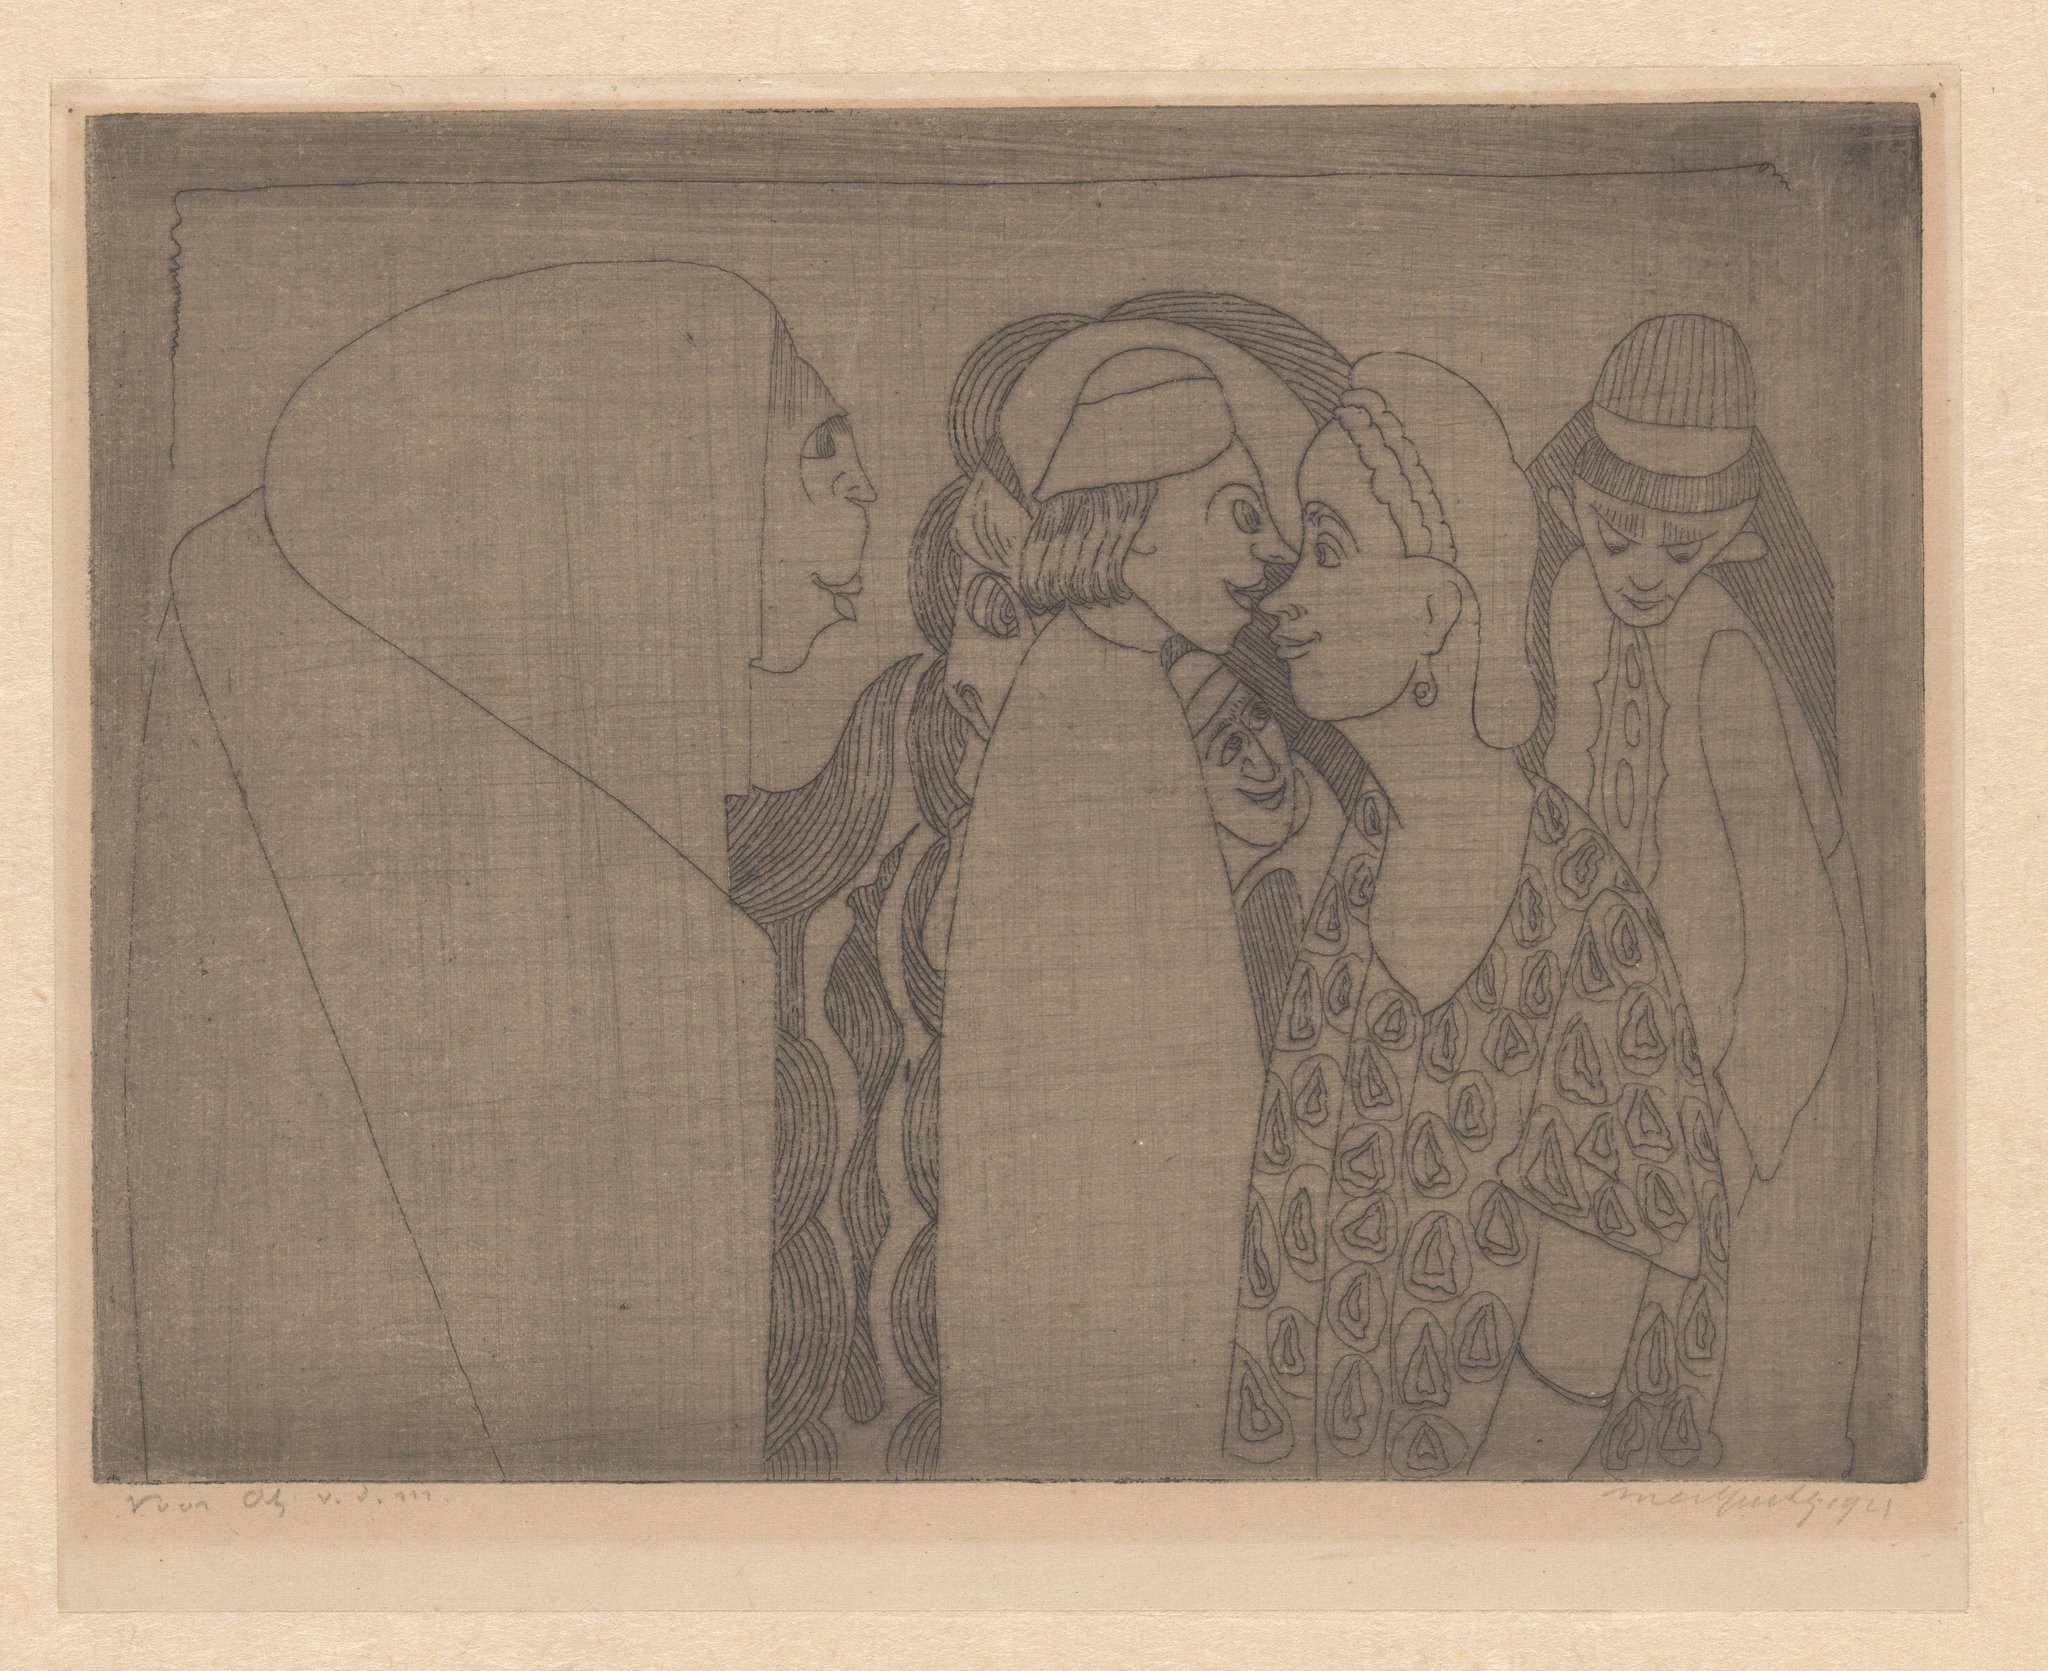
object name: print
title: Fantasie: diverse figuren, een paartje in het midden (vrouw in jrk met decoratieve driehoeken), links een figuur in enkele lijnen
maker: samuel jessurun de mesquita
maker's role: draughtsman, print maker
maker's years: 1868-1944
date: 1921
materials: paper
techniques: etching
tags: caricatures (human types), head-gear: hood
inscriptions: collector's mark: Lugt 2228, dedication: ‘voor Ot v.d.m.’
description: Links een figuur met een kap; rechts een vrouw in een gebloemde jurk.